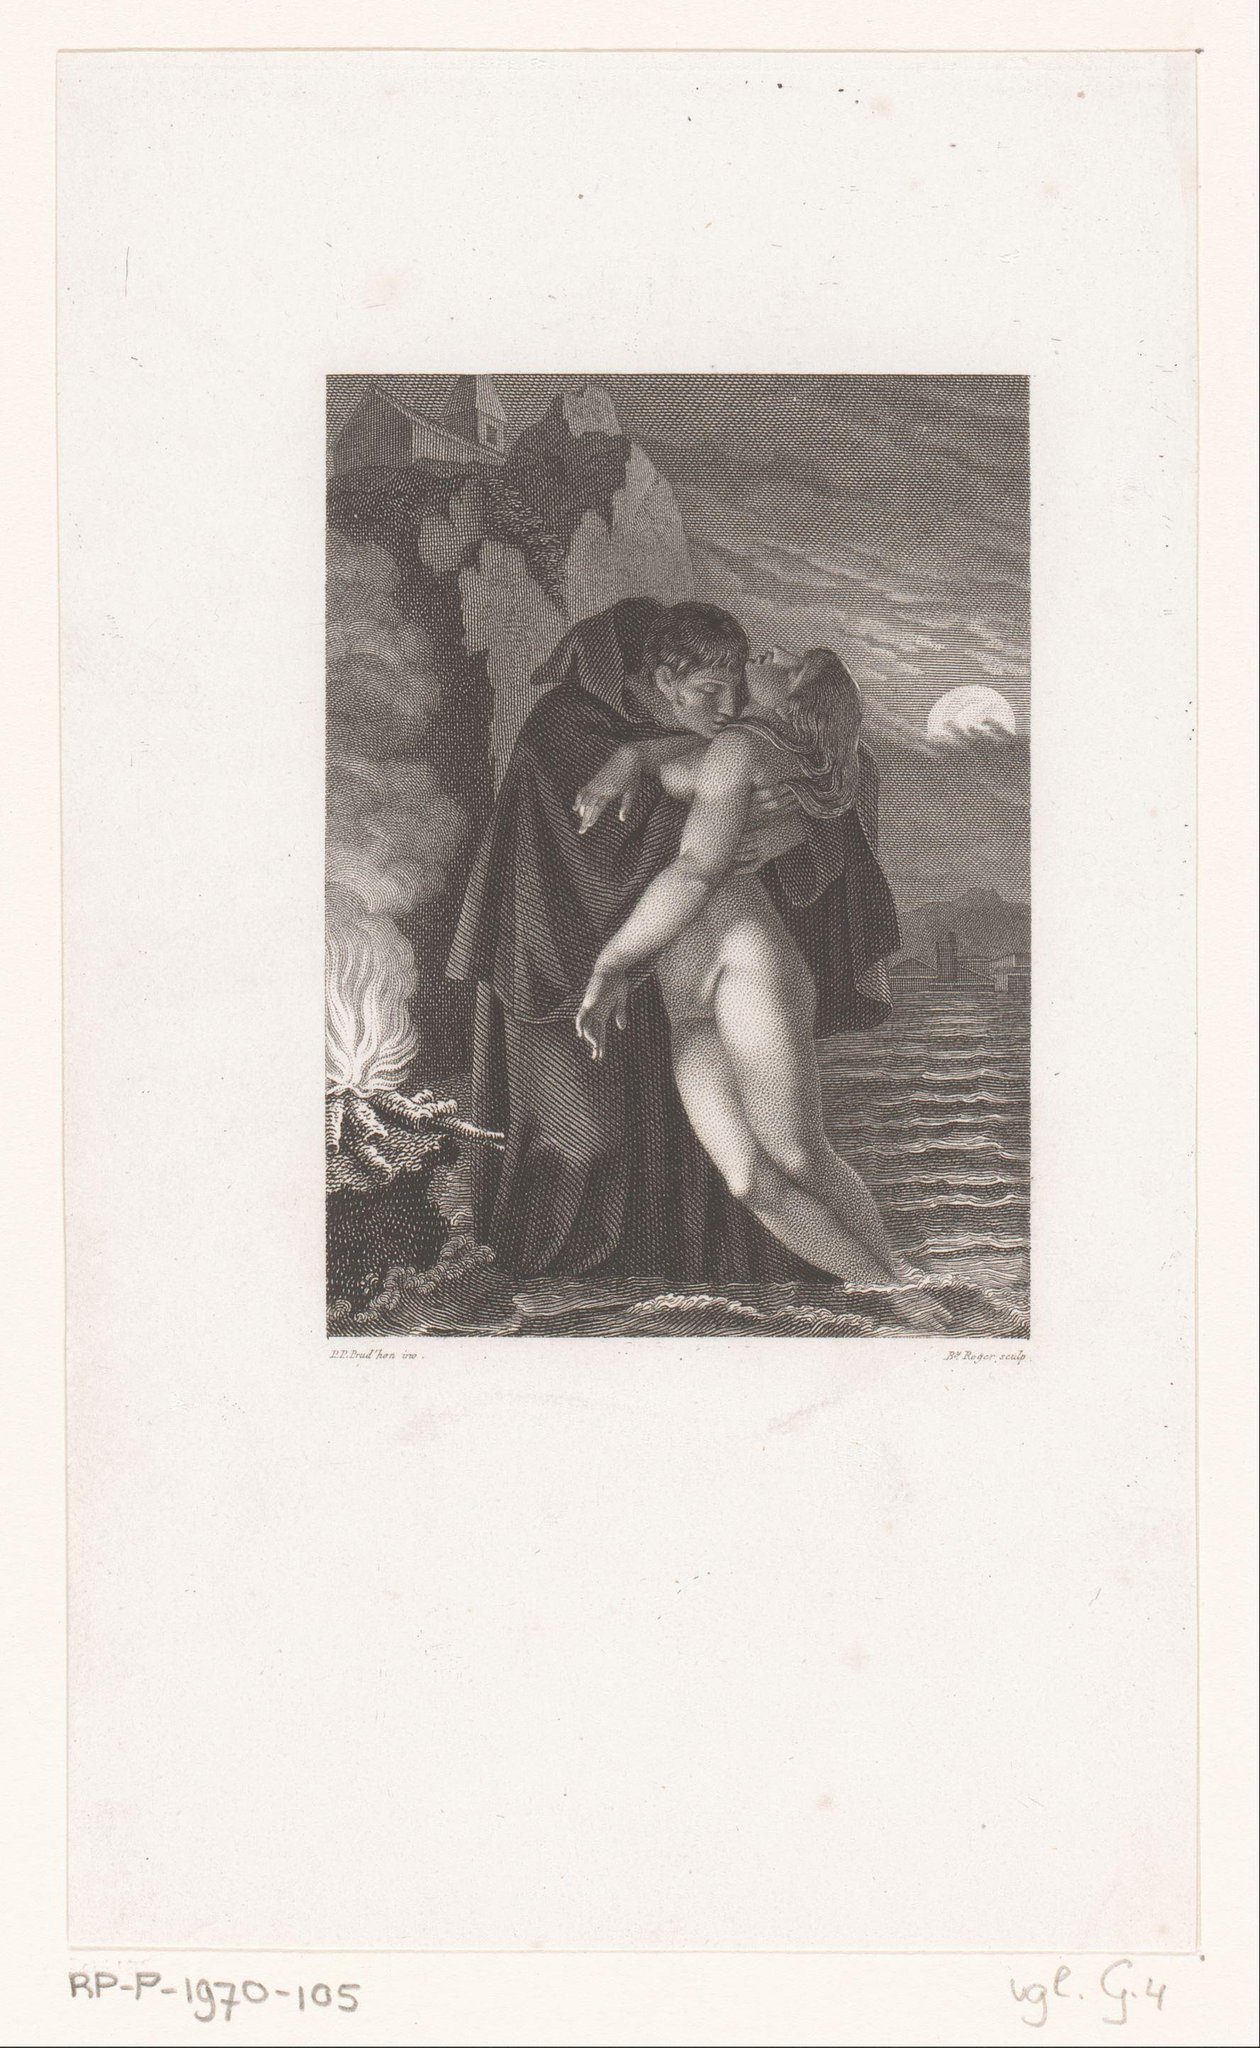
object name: print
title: Phrosine en Mélidore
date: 1797-1841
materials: paper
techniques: etching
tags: saving a person from drowning, couple of lovers, sea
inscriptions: collector's mark: Lugt 2228, collector's mark: Lugt 2760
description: Scène uit het gedicht van Pierre-Joseph Bernard. Mélidore redt zijn geliefde Phrosine uit de zee.